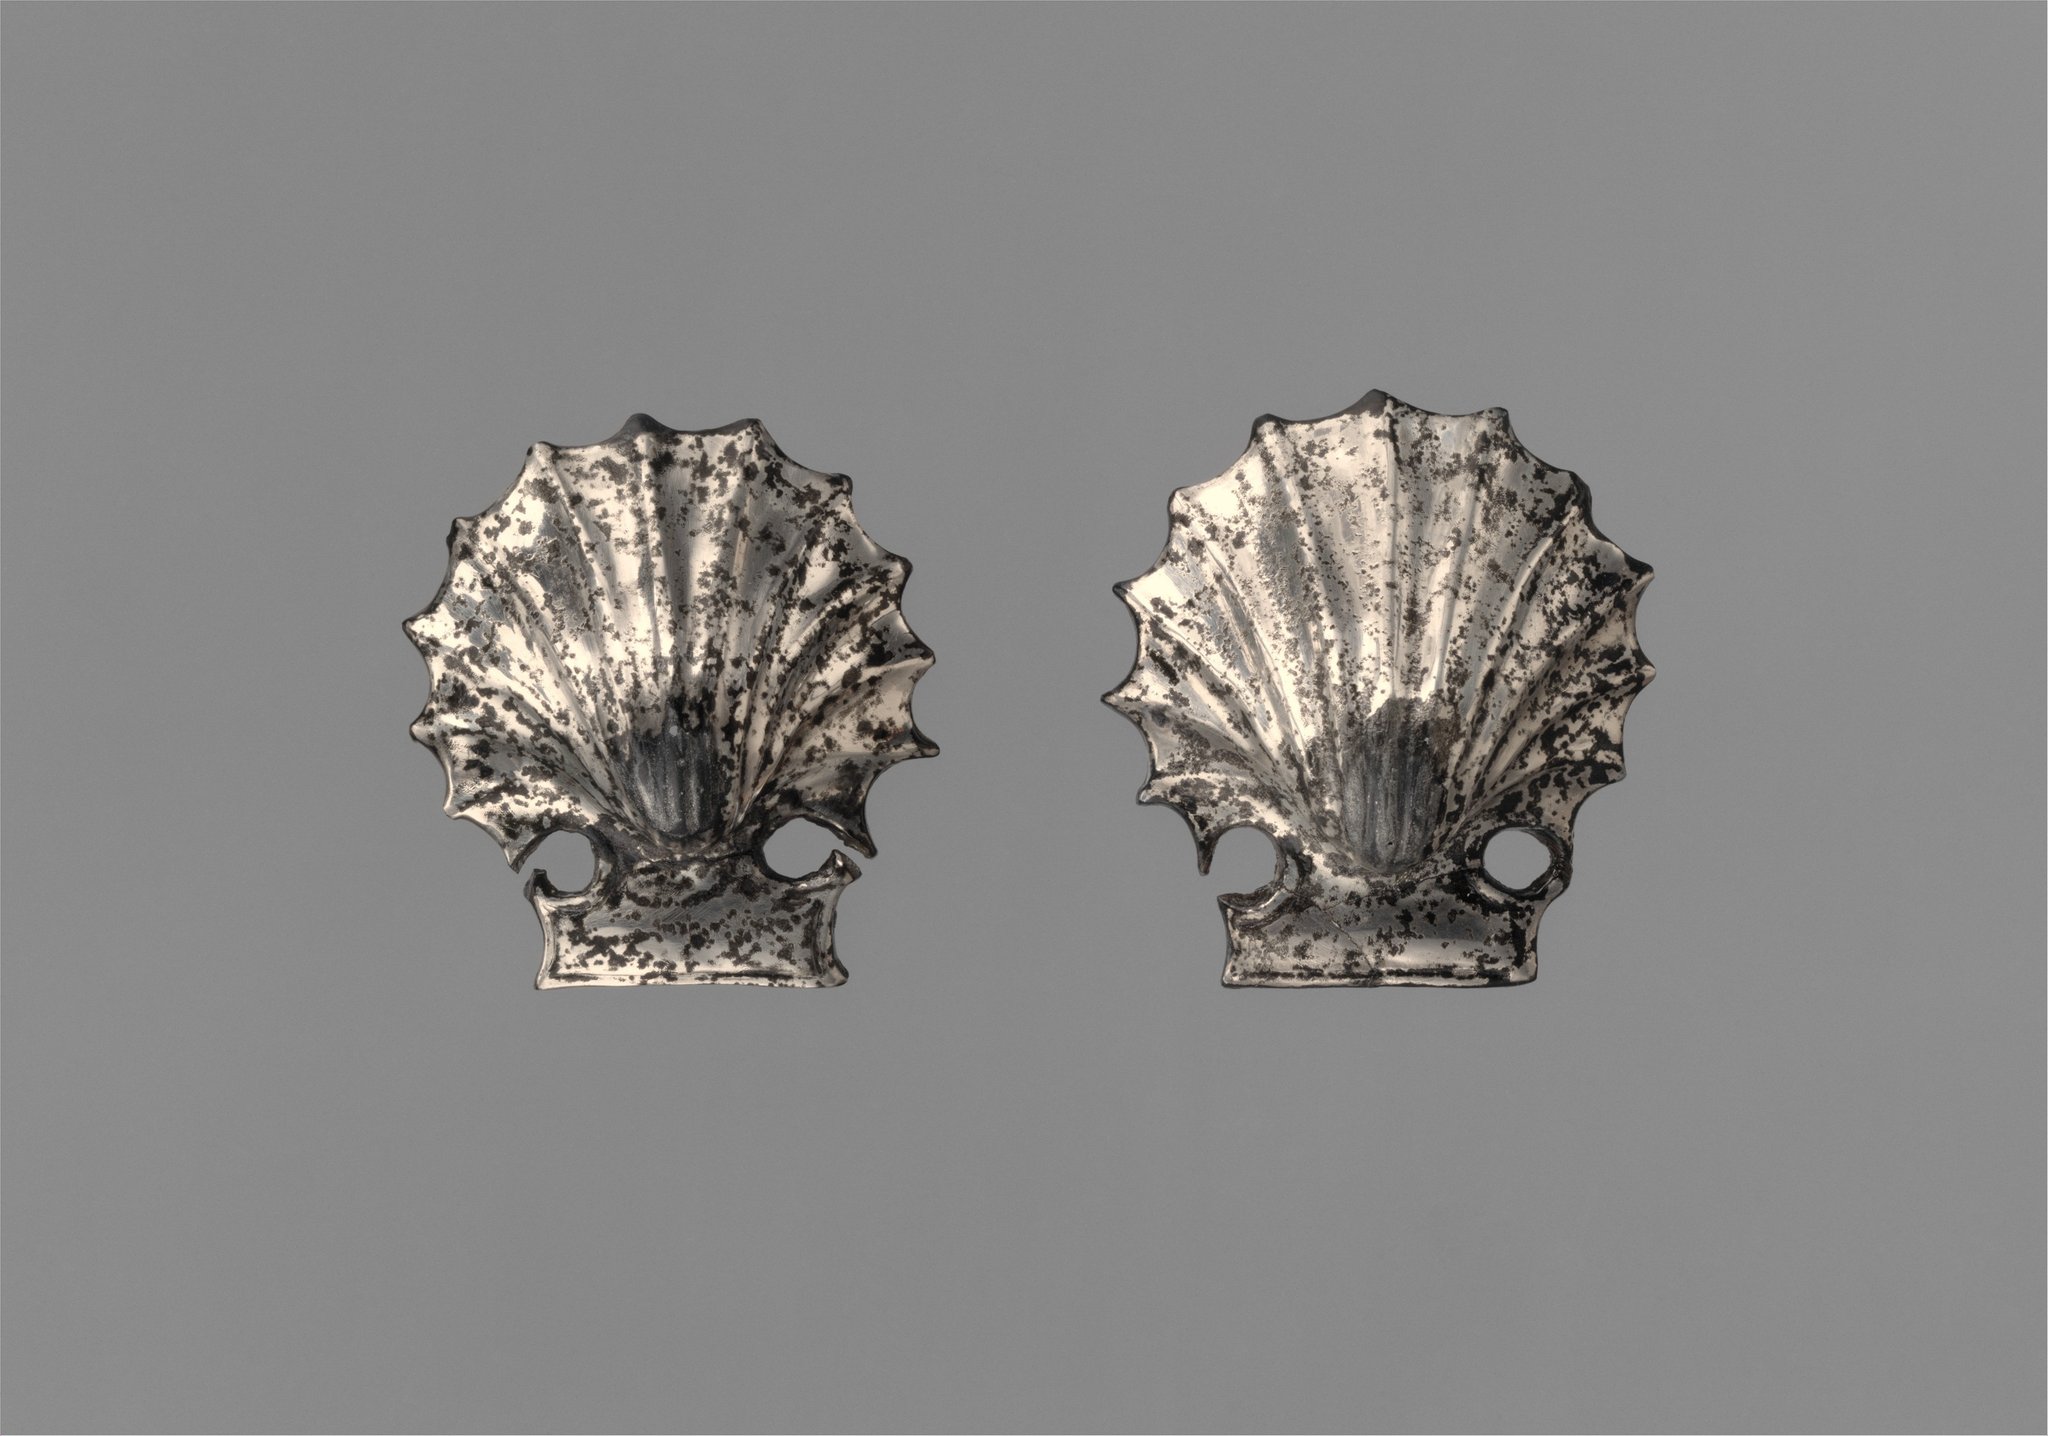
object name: appliqués in the form of scallop shell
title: Pair of silver attachments in the form of seashells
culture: greek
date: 334-201 BCE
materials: silver